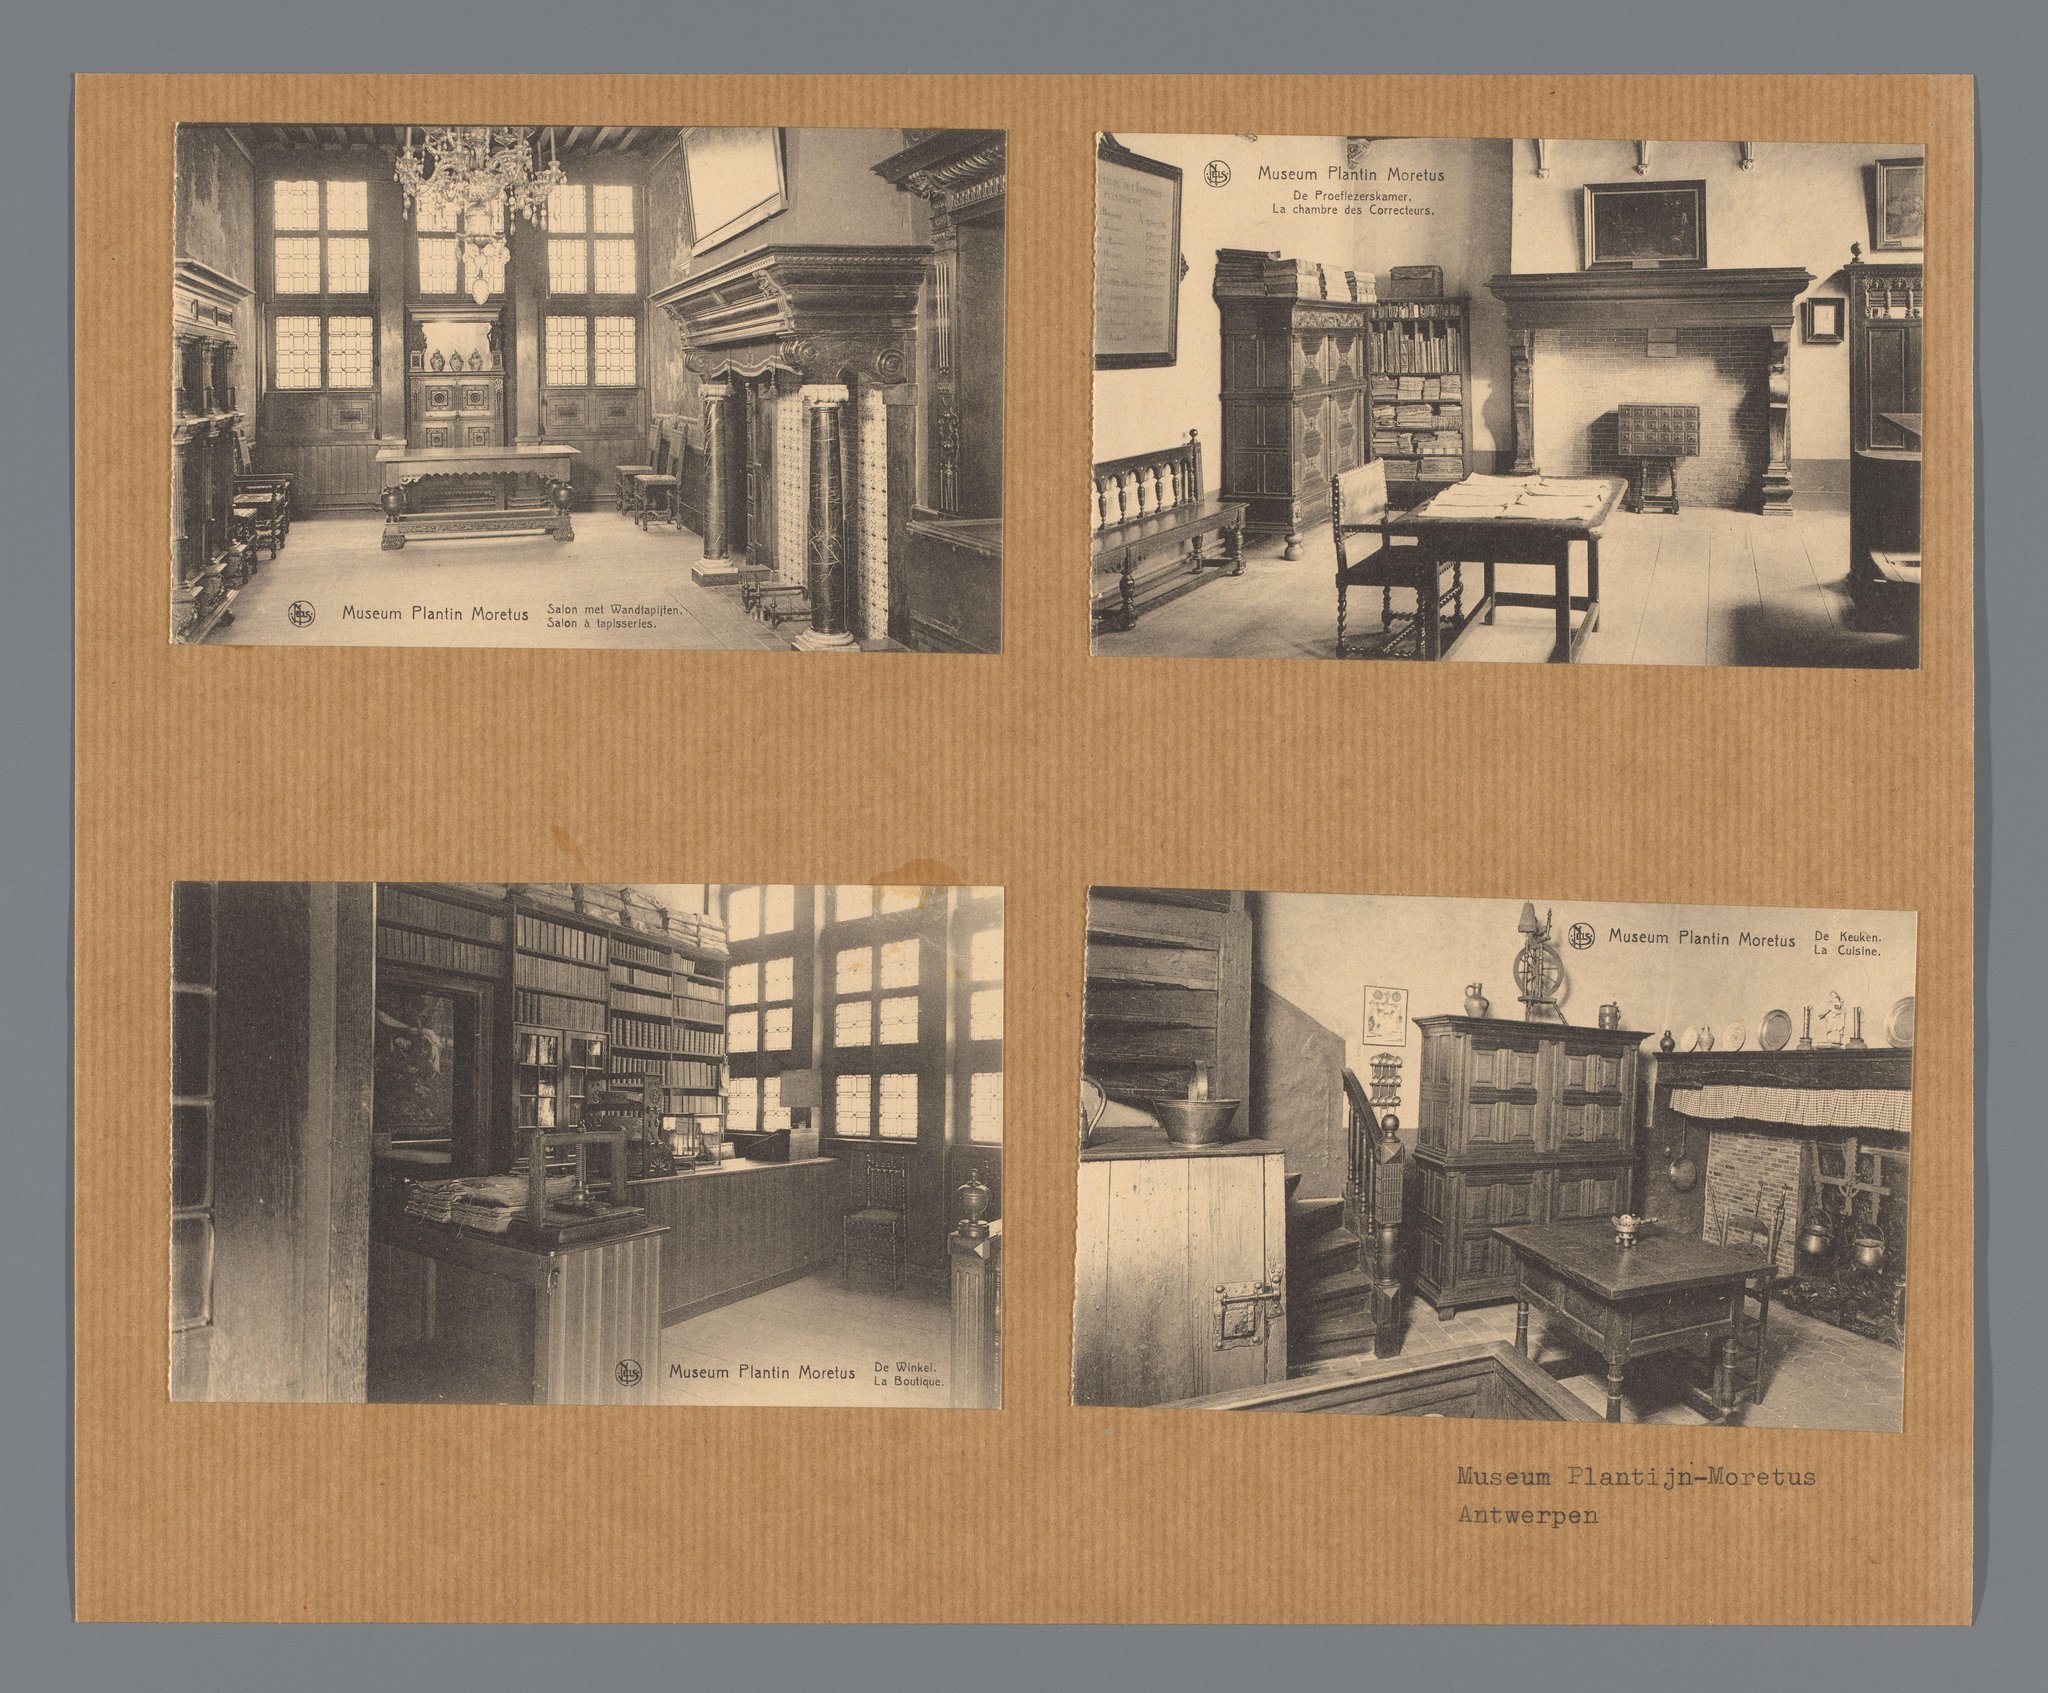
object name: photograph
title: Antwerpen. Museum Plantijn - Moretus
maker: Anonymous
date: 1860-1925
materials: photographic support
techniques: photograph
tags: museum plantin-moretus